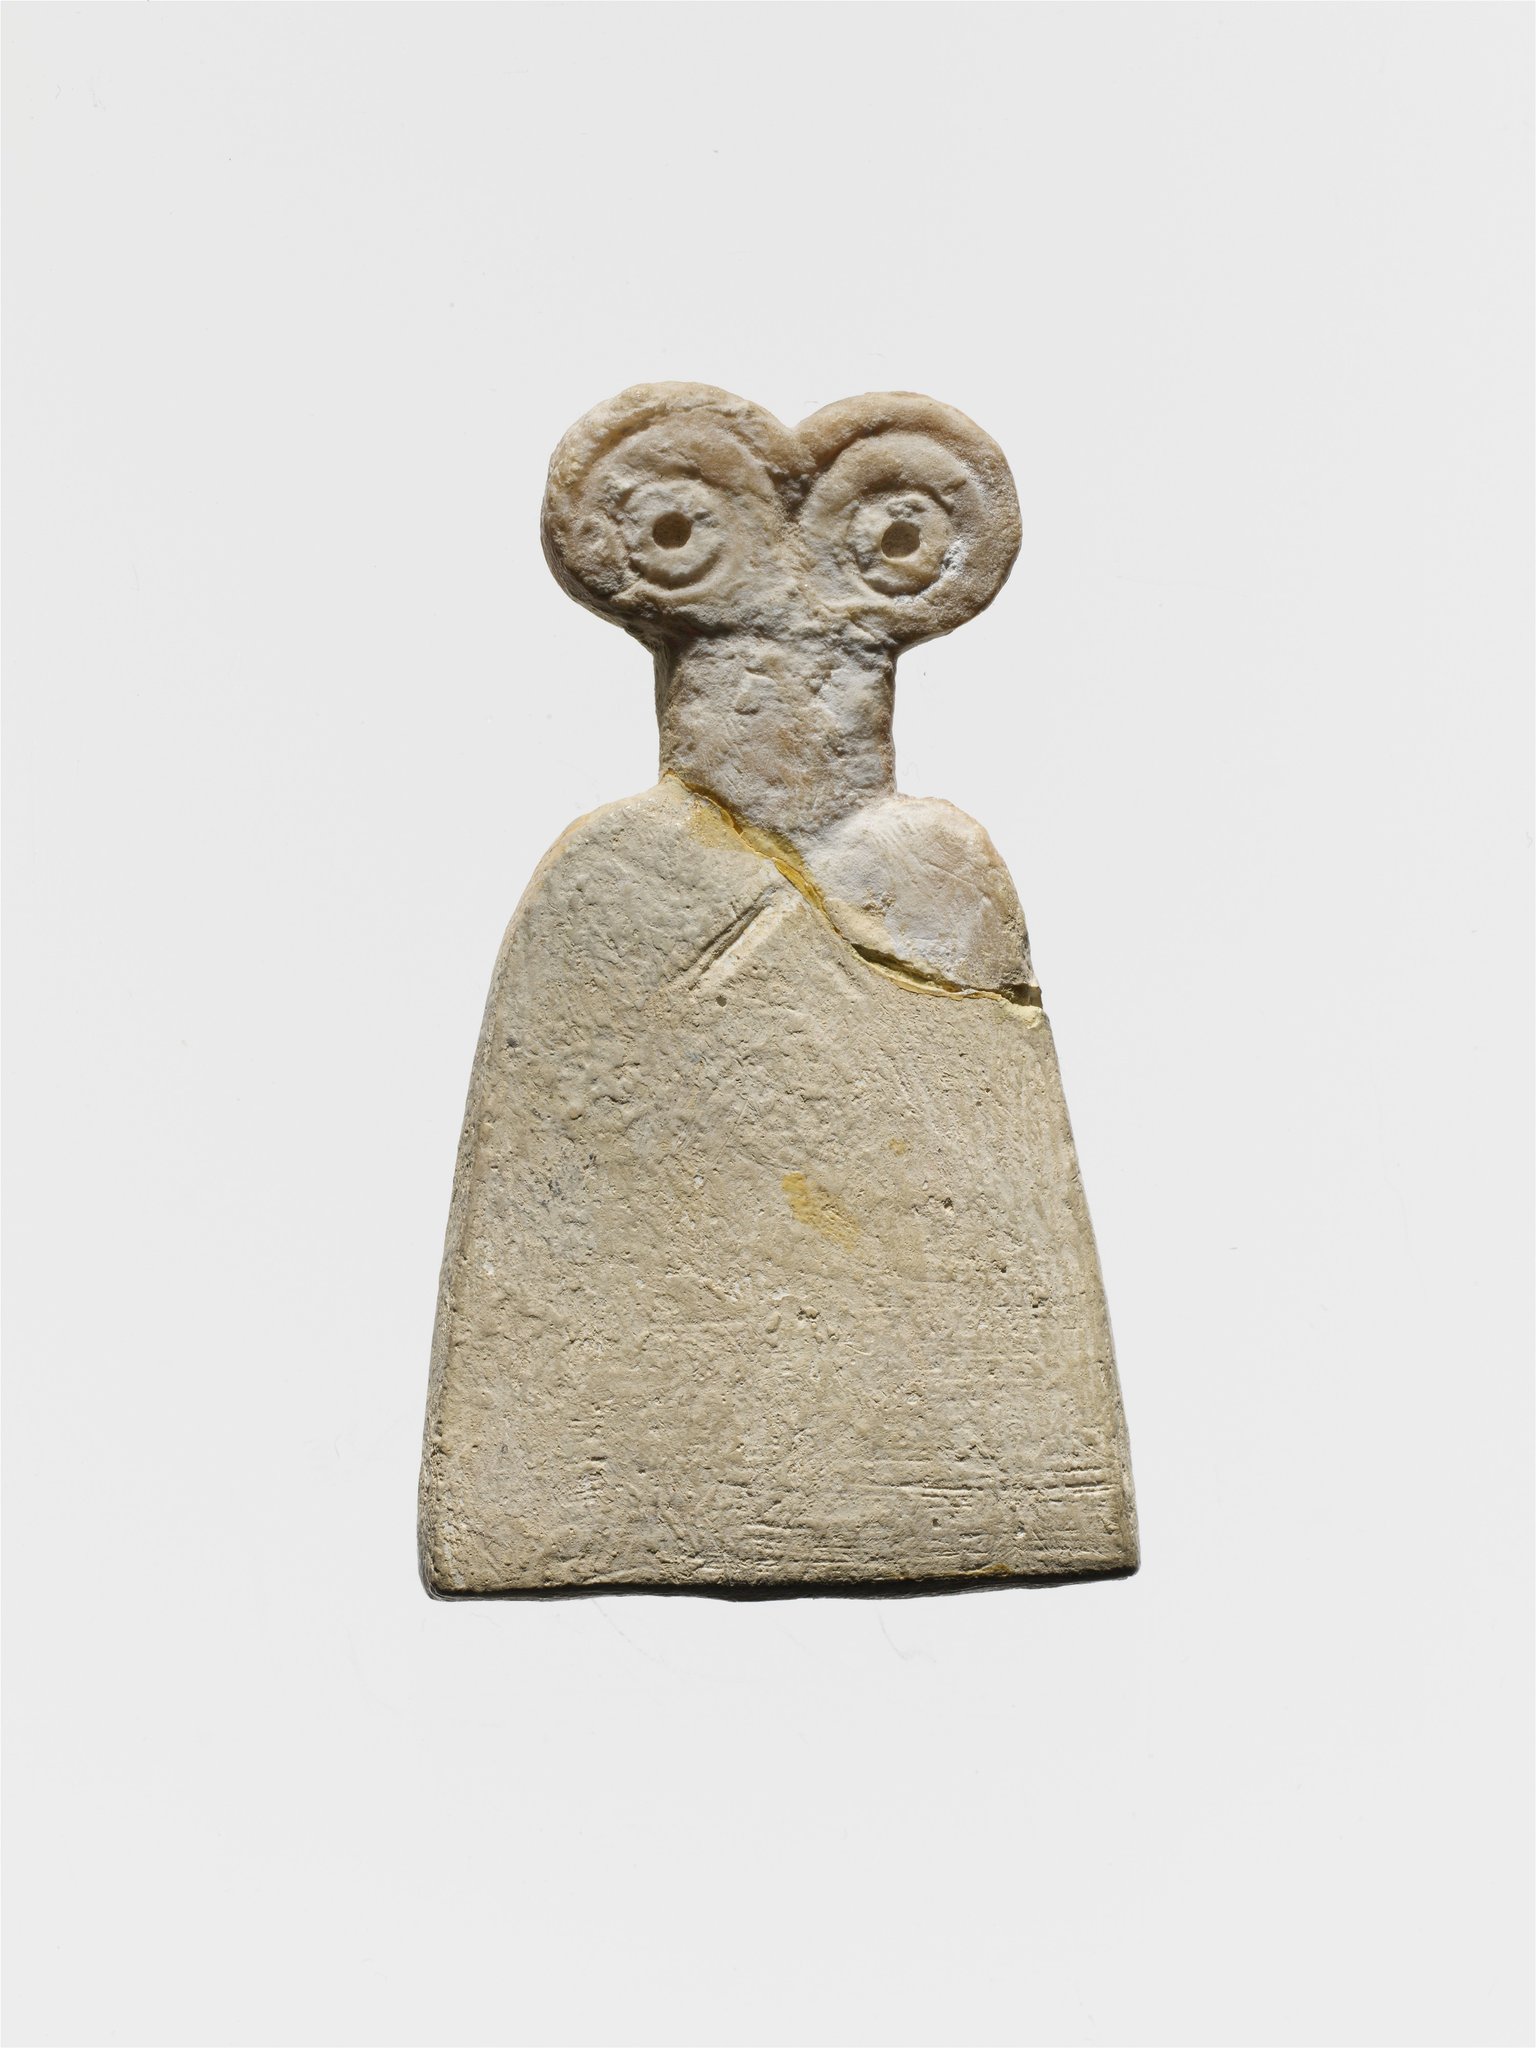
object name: sculpture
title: Eye idol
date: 3700-3500 BCE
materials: alabaster, gypsum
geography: syria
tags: eyes